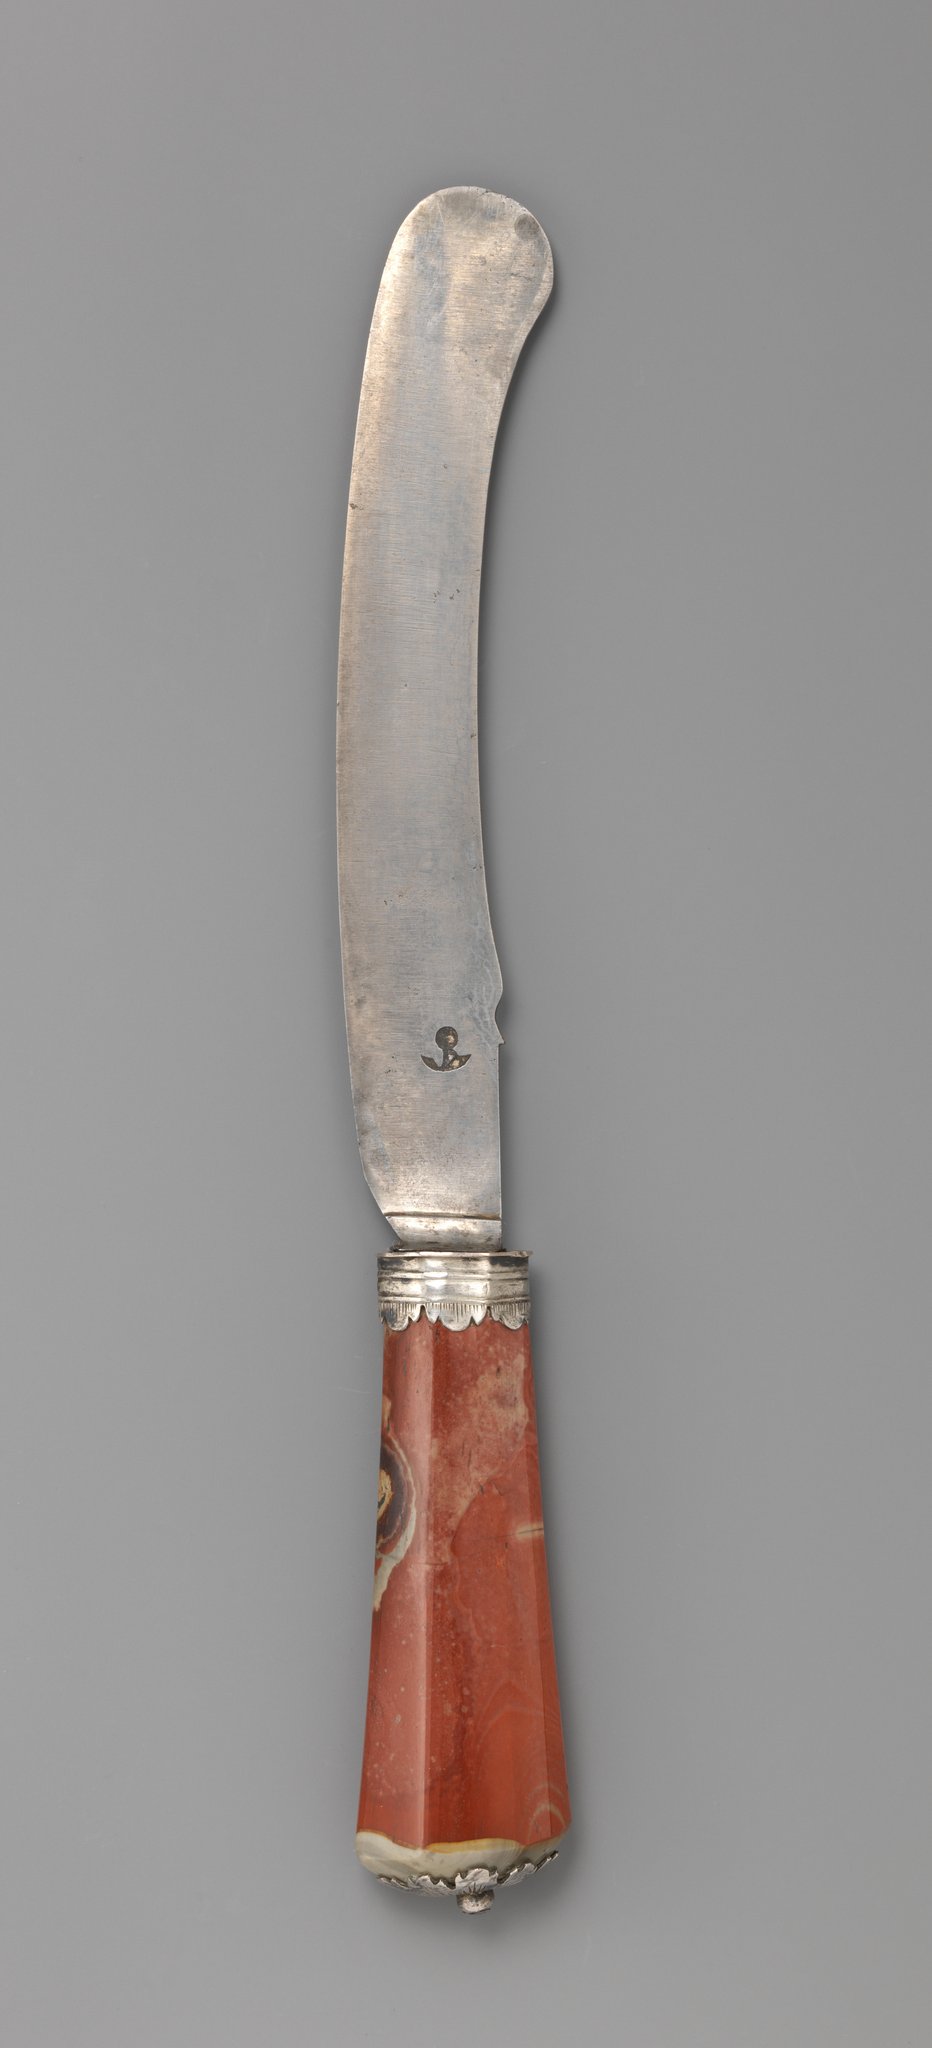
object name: table knife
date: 1701-1800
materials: stone, silver, steel